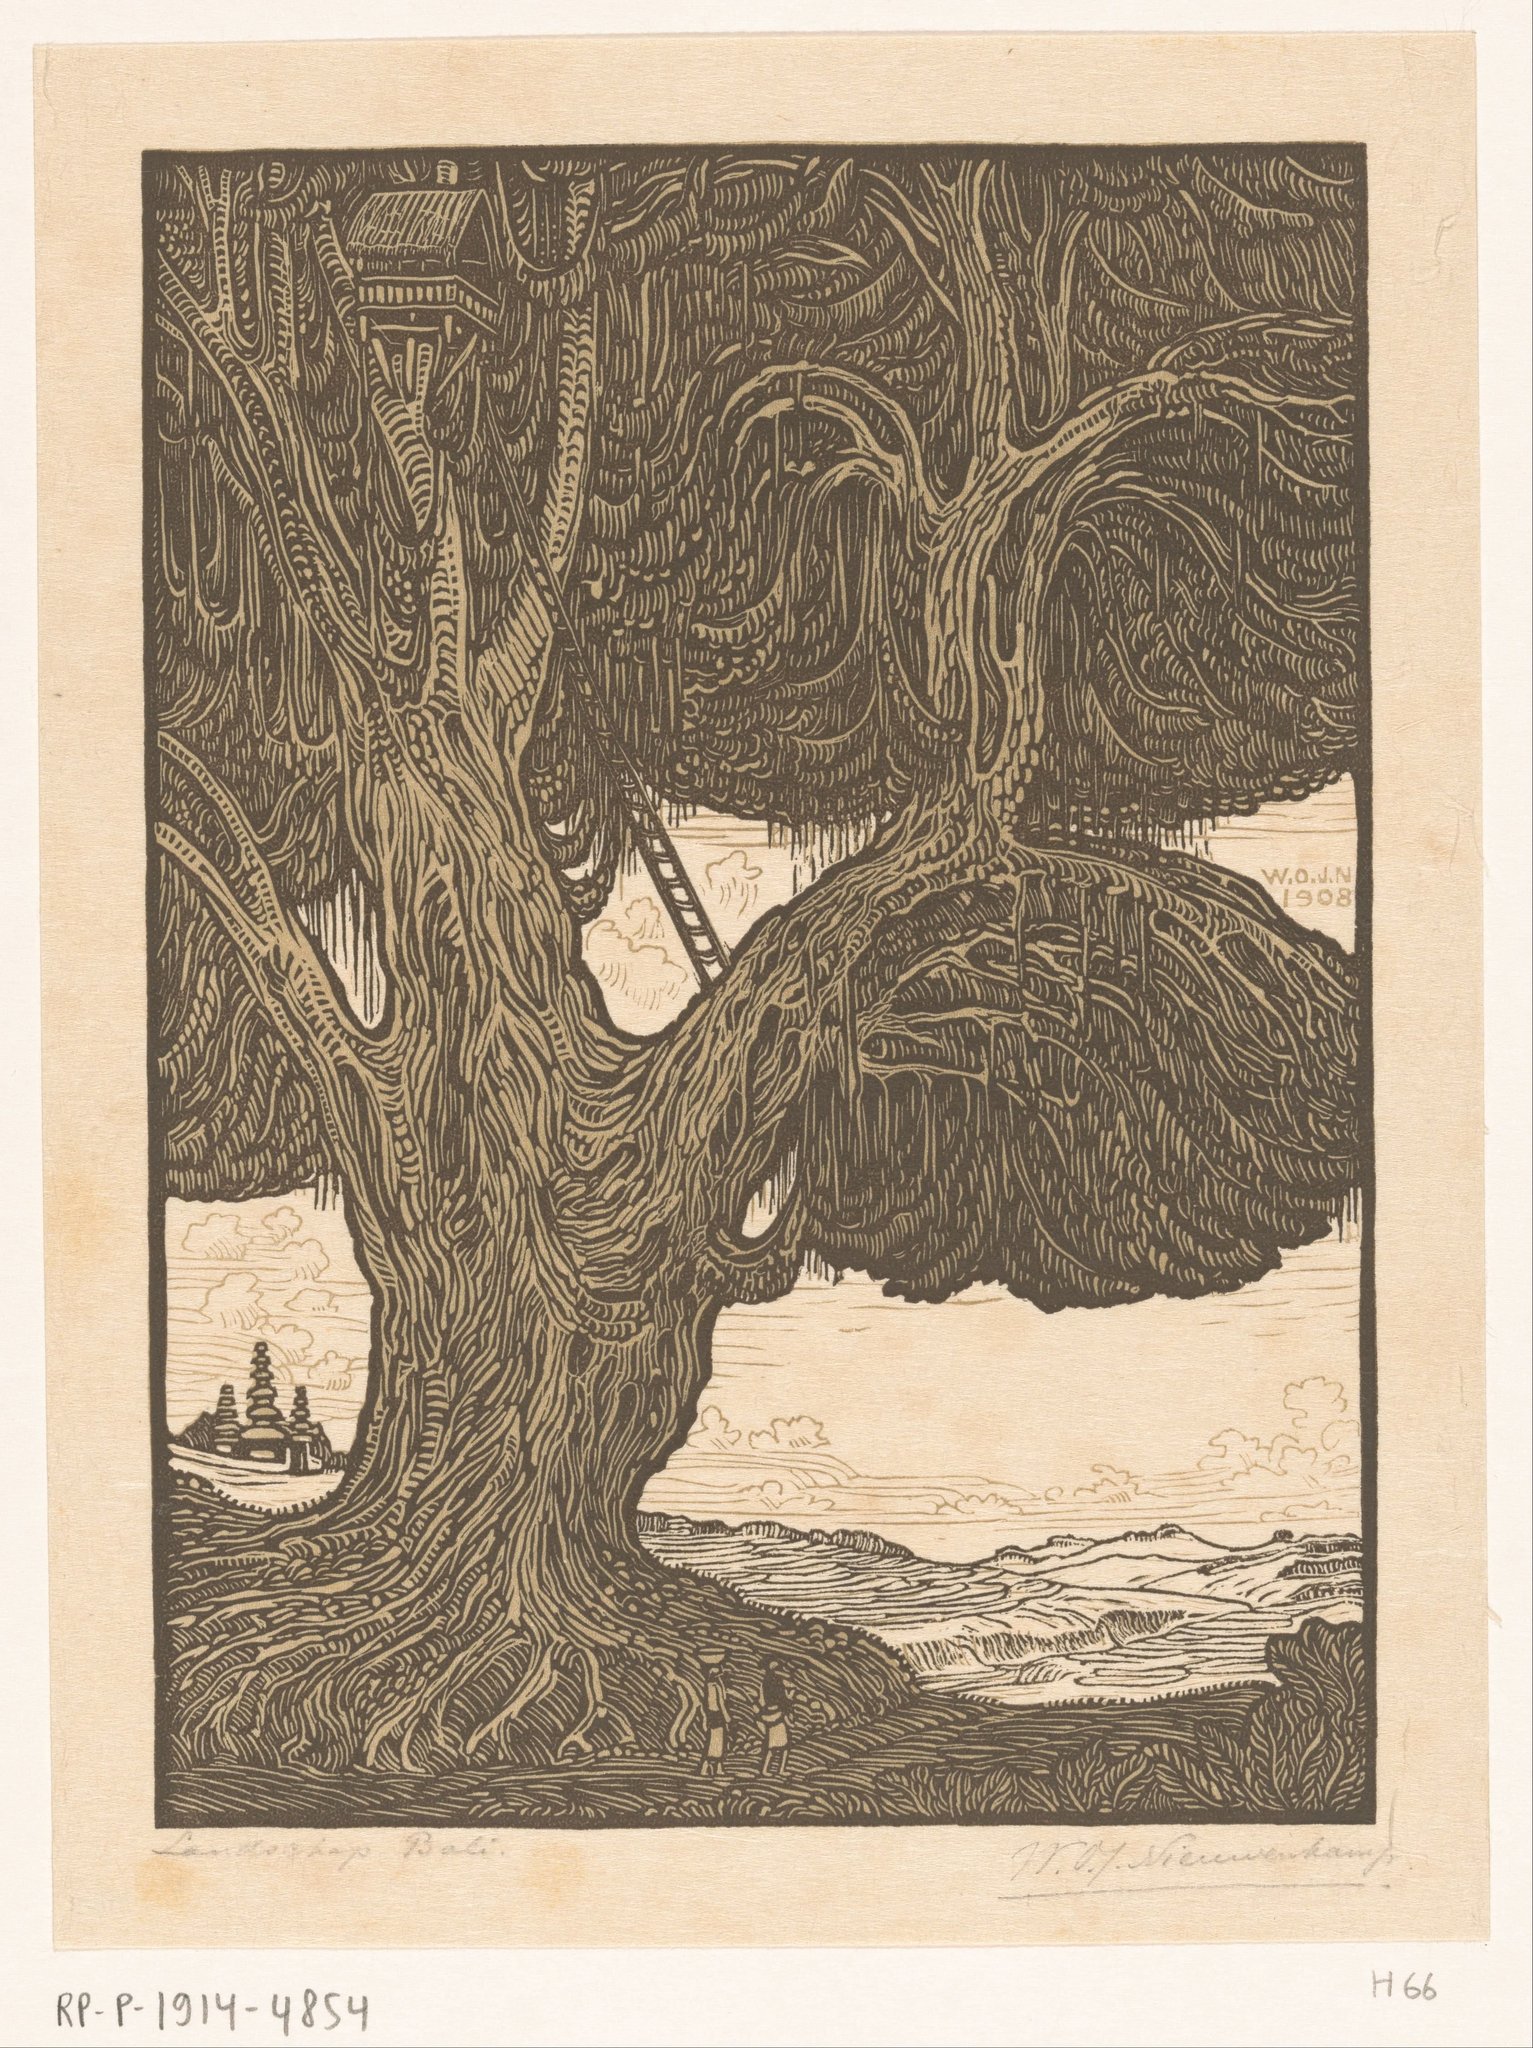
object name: print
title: Landschap Bali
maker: wijnand otto jan nieuwenkamp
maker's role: draughtsman, print maker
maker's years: 1874-1950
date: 1908-1909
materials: paper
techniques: woodcut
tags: trees, ladder, hut, cabin, lodge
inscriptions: collector's mark: Lugt 2233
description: Er bevindt zich een ladder in de waringin, die toegang geeft tot de boomhut. Op de voorgrond twee figuren die wandelen op een pad. Links op de achtergrond een tempel.